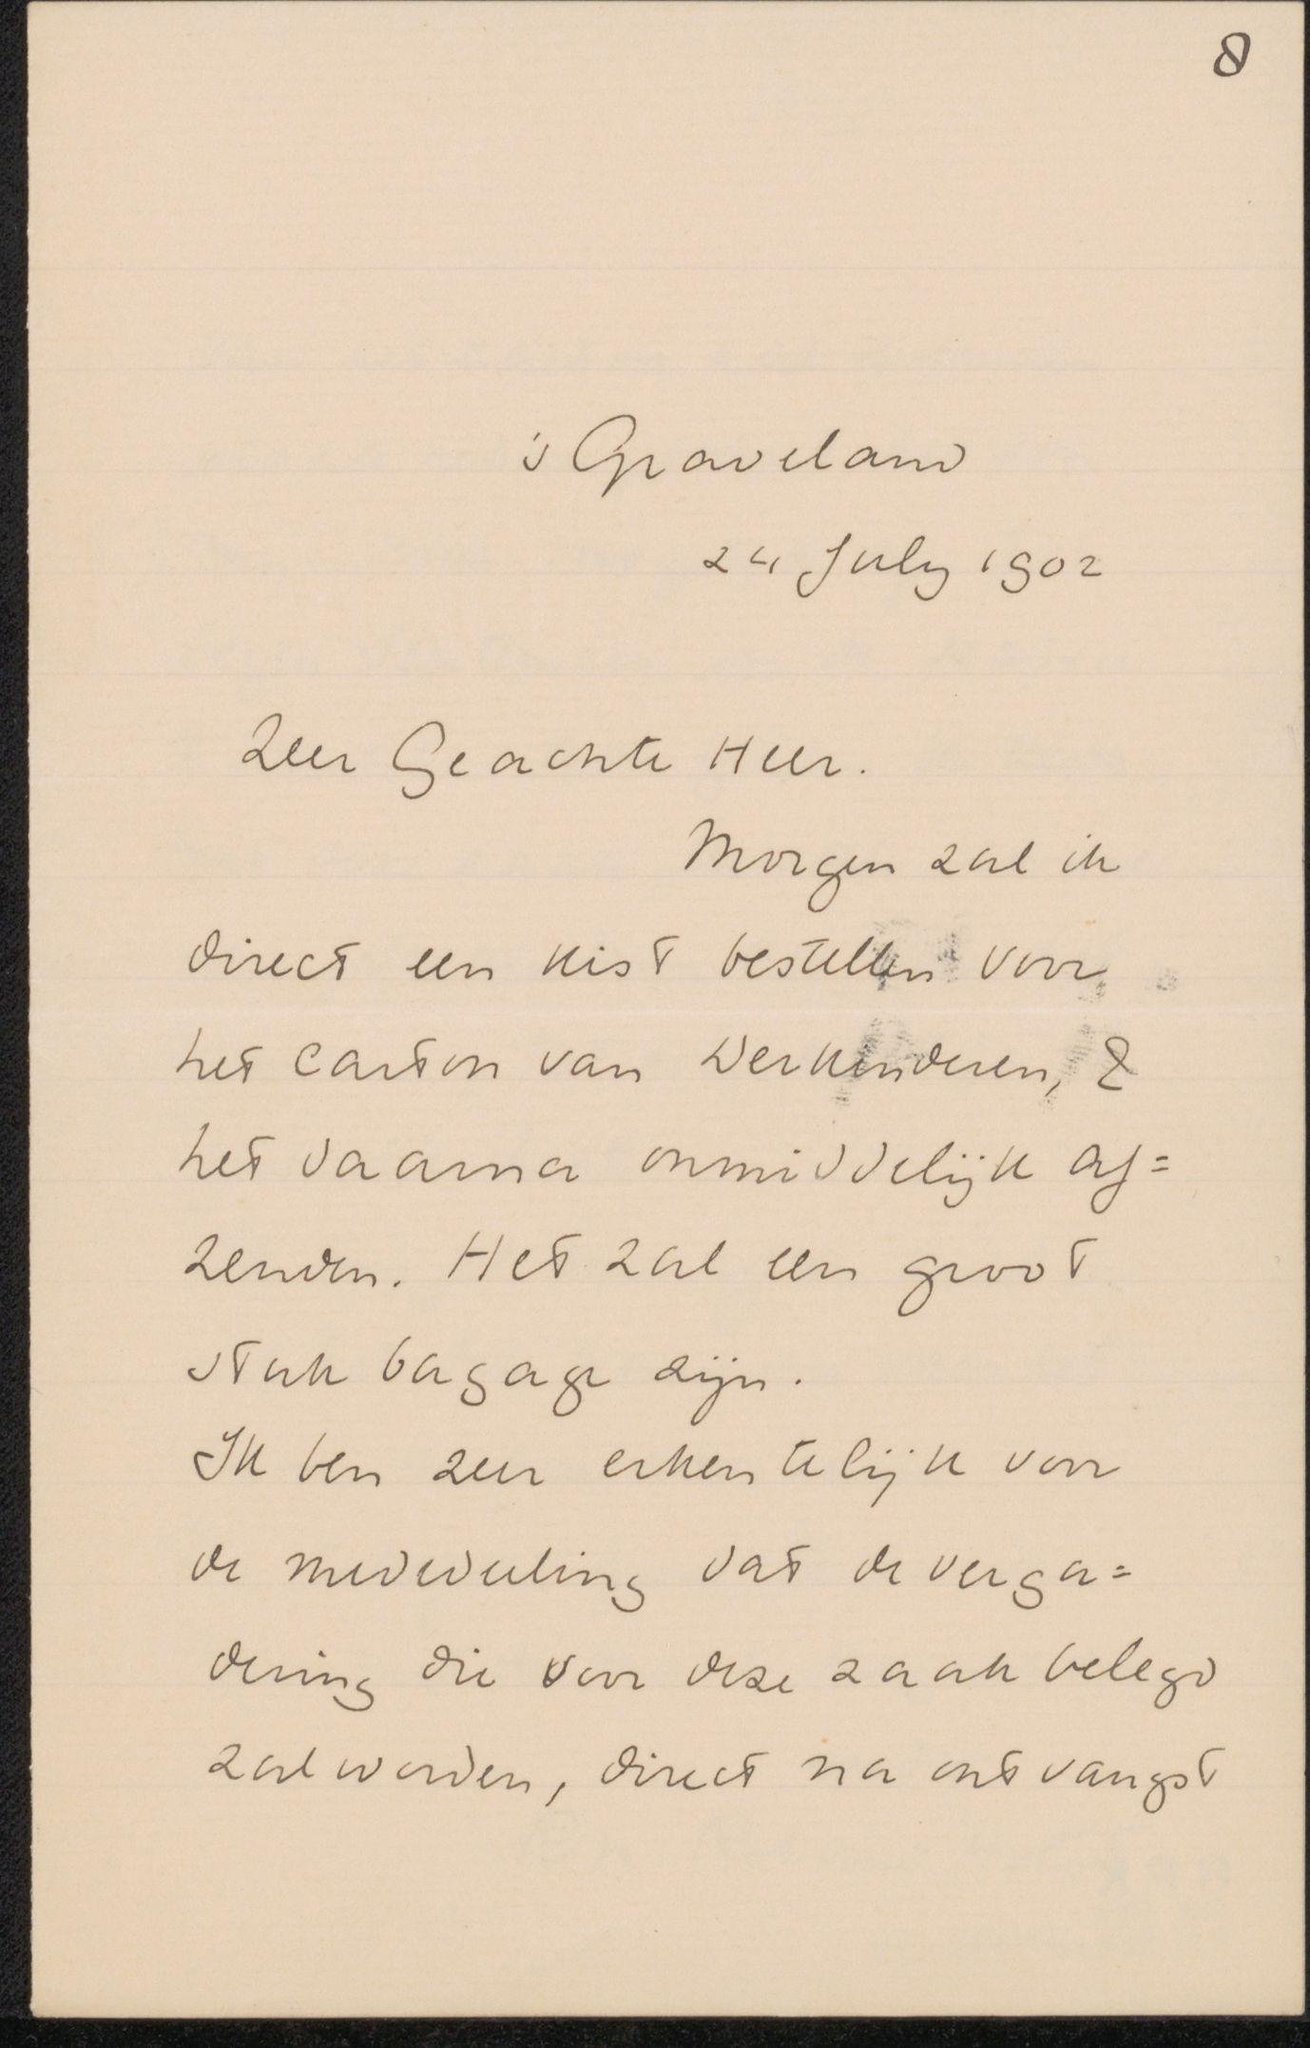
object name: letter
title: Brief aan Pieter Haverkorn van Rijsewijk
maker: richard nicolaüs roland holst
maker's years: 1868-1938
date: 1902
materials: ink, paper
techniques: pen, writing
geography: s-graveland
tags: den bosch, painter, print maker, draughtsman, antoon derkinderen, pieter haverkorn van rijsewijk, applied arts, arts and crafts; industrial design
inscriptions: collector's mark: ‘RPK’, watermark